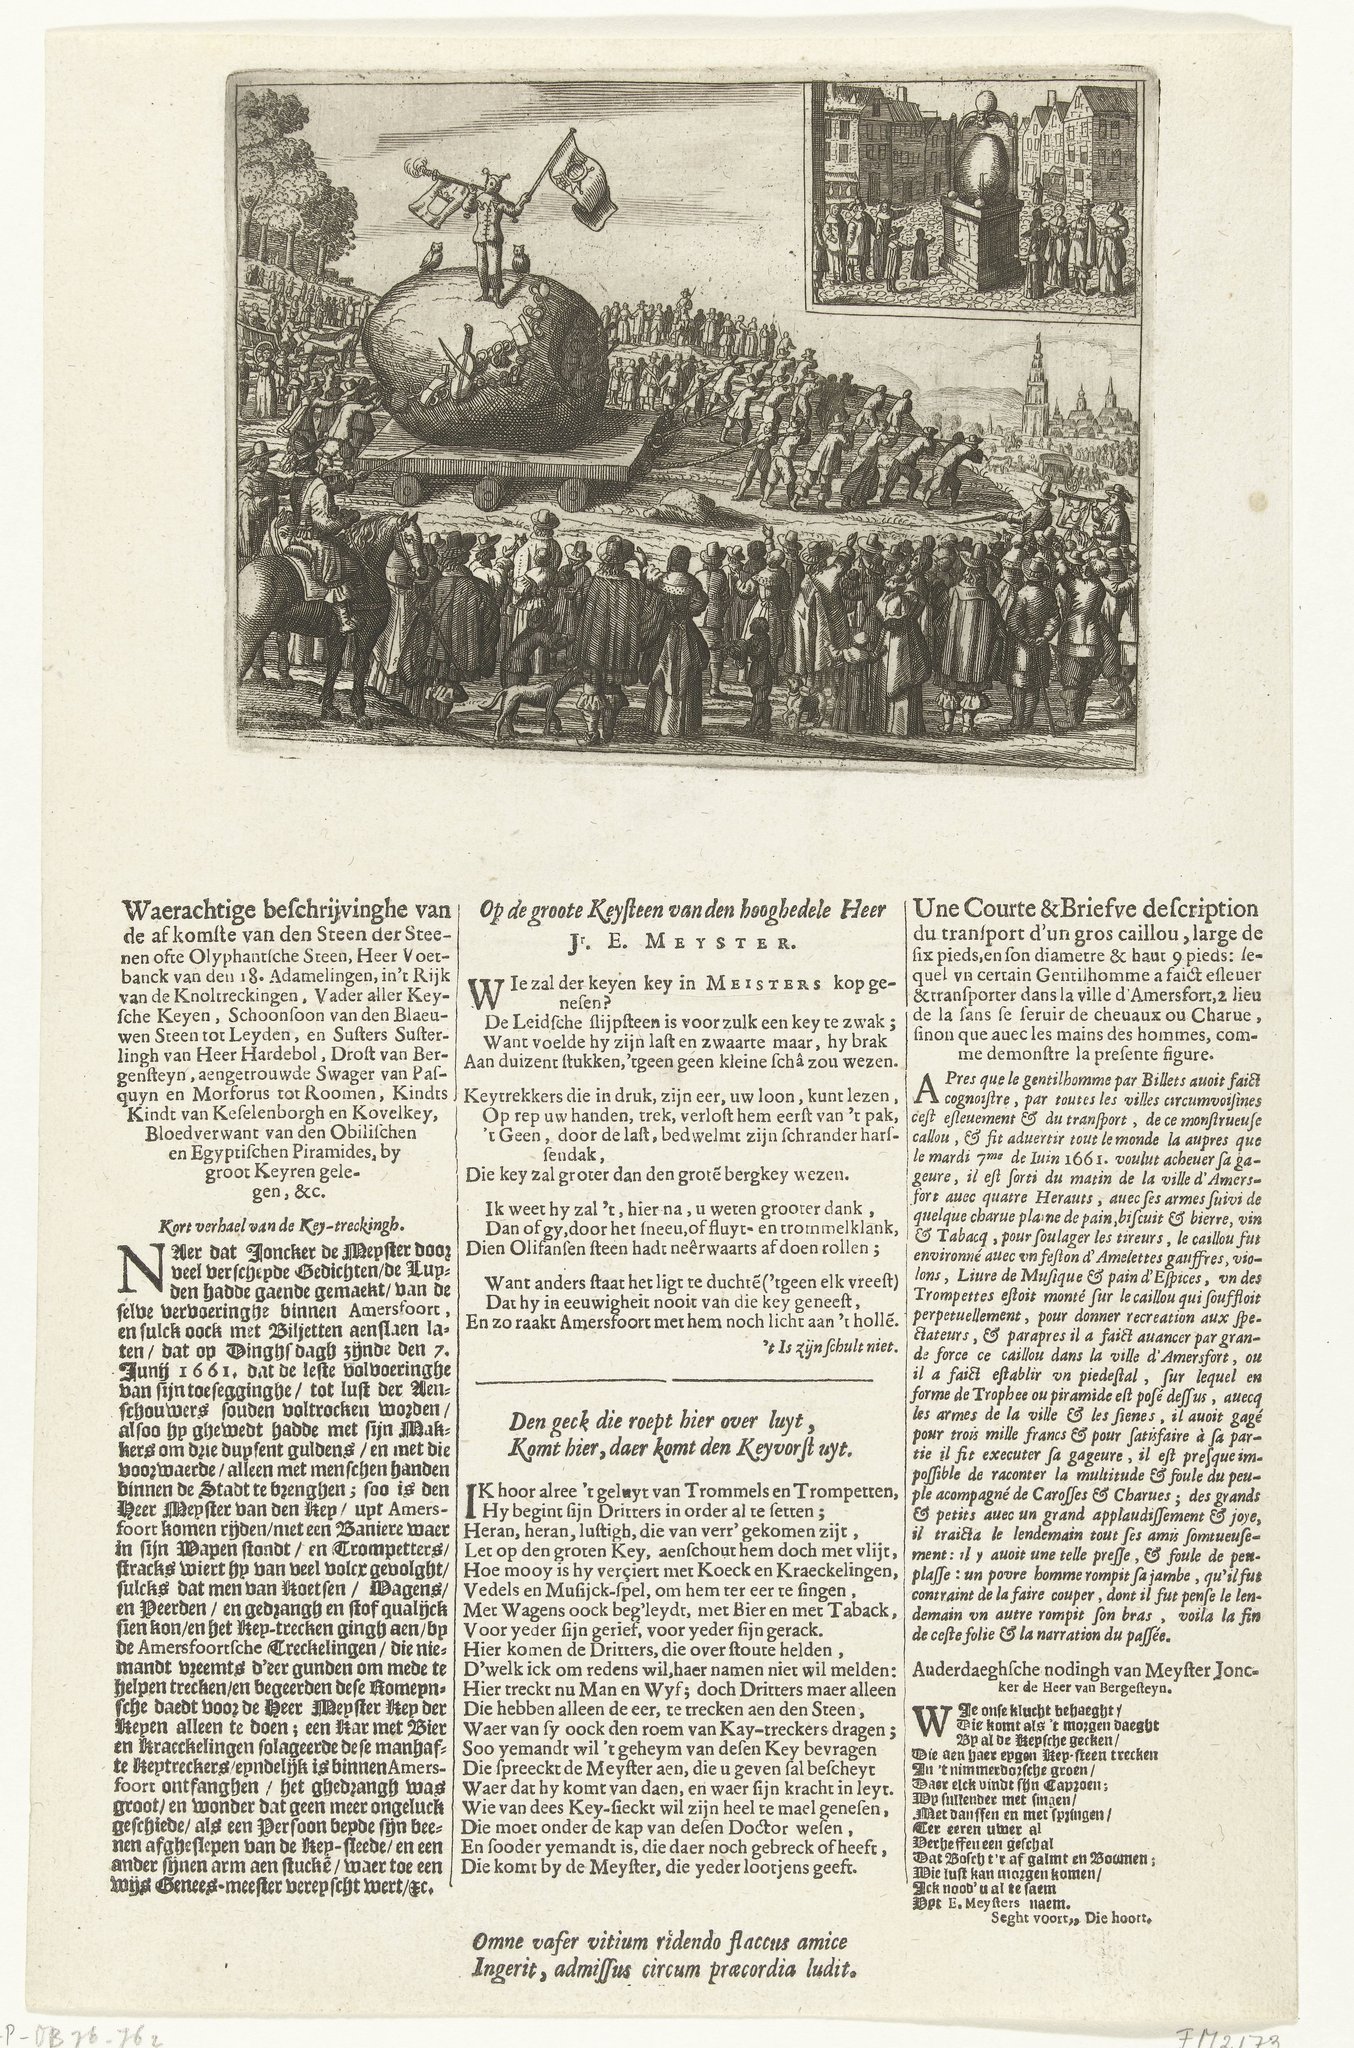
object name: cartoon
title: De Amersfoortse Steentrekking, 1661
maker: Anonymous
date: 1661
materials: paper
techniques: etching, letterpress printing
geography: northern netherlands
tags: utrecht, unusual means of transport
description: Spotprent op de Amersfoortse Steentrekking. Op 7 juni 1661 wordt onder leiding van jhr. Everard Meyster een grote kei (de Amersfoortse Kei) vanuit de Leusderheide naar de Varkensmarkt in de binnenstad van Amersfoort getrokken. De kei wordt liggend op een rolwagen door mannnen met touwen voort getrokken. Op de kei staat een nar met bazuin en vaandels en twee uilen, om de kei een krans van krakelingen en een viool. Met een grote menigte van toeschouwers, in de verte Amersfoort. Met een inzet met een plaatje van de kei op een voetstuk op de markt. Op het blad onder de plaat gedrukt drie kolommen tekst met spotverzen op de "dolle jonker" Meyster, in het Nederlands en Frans.